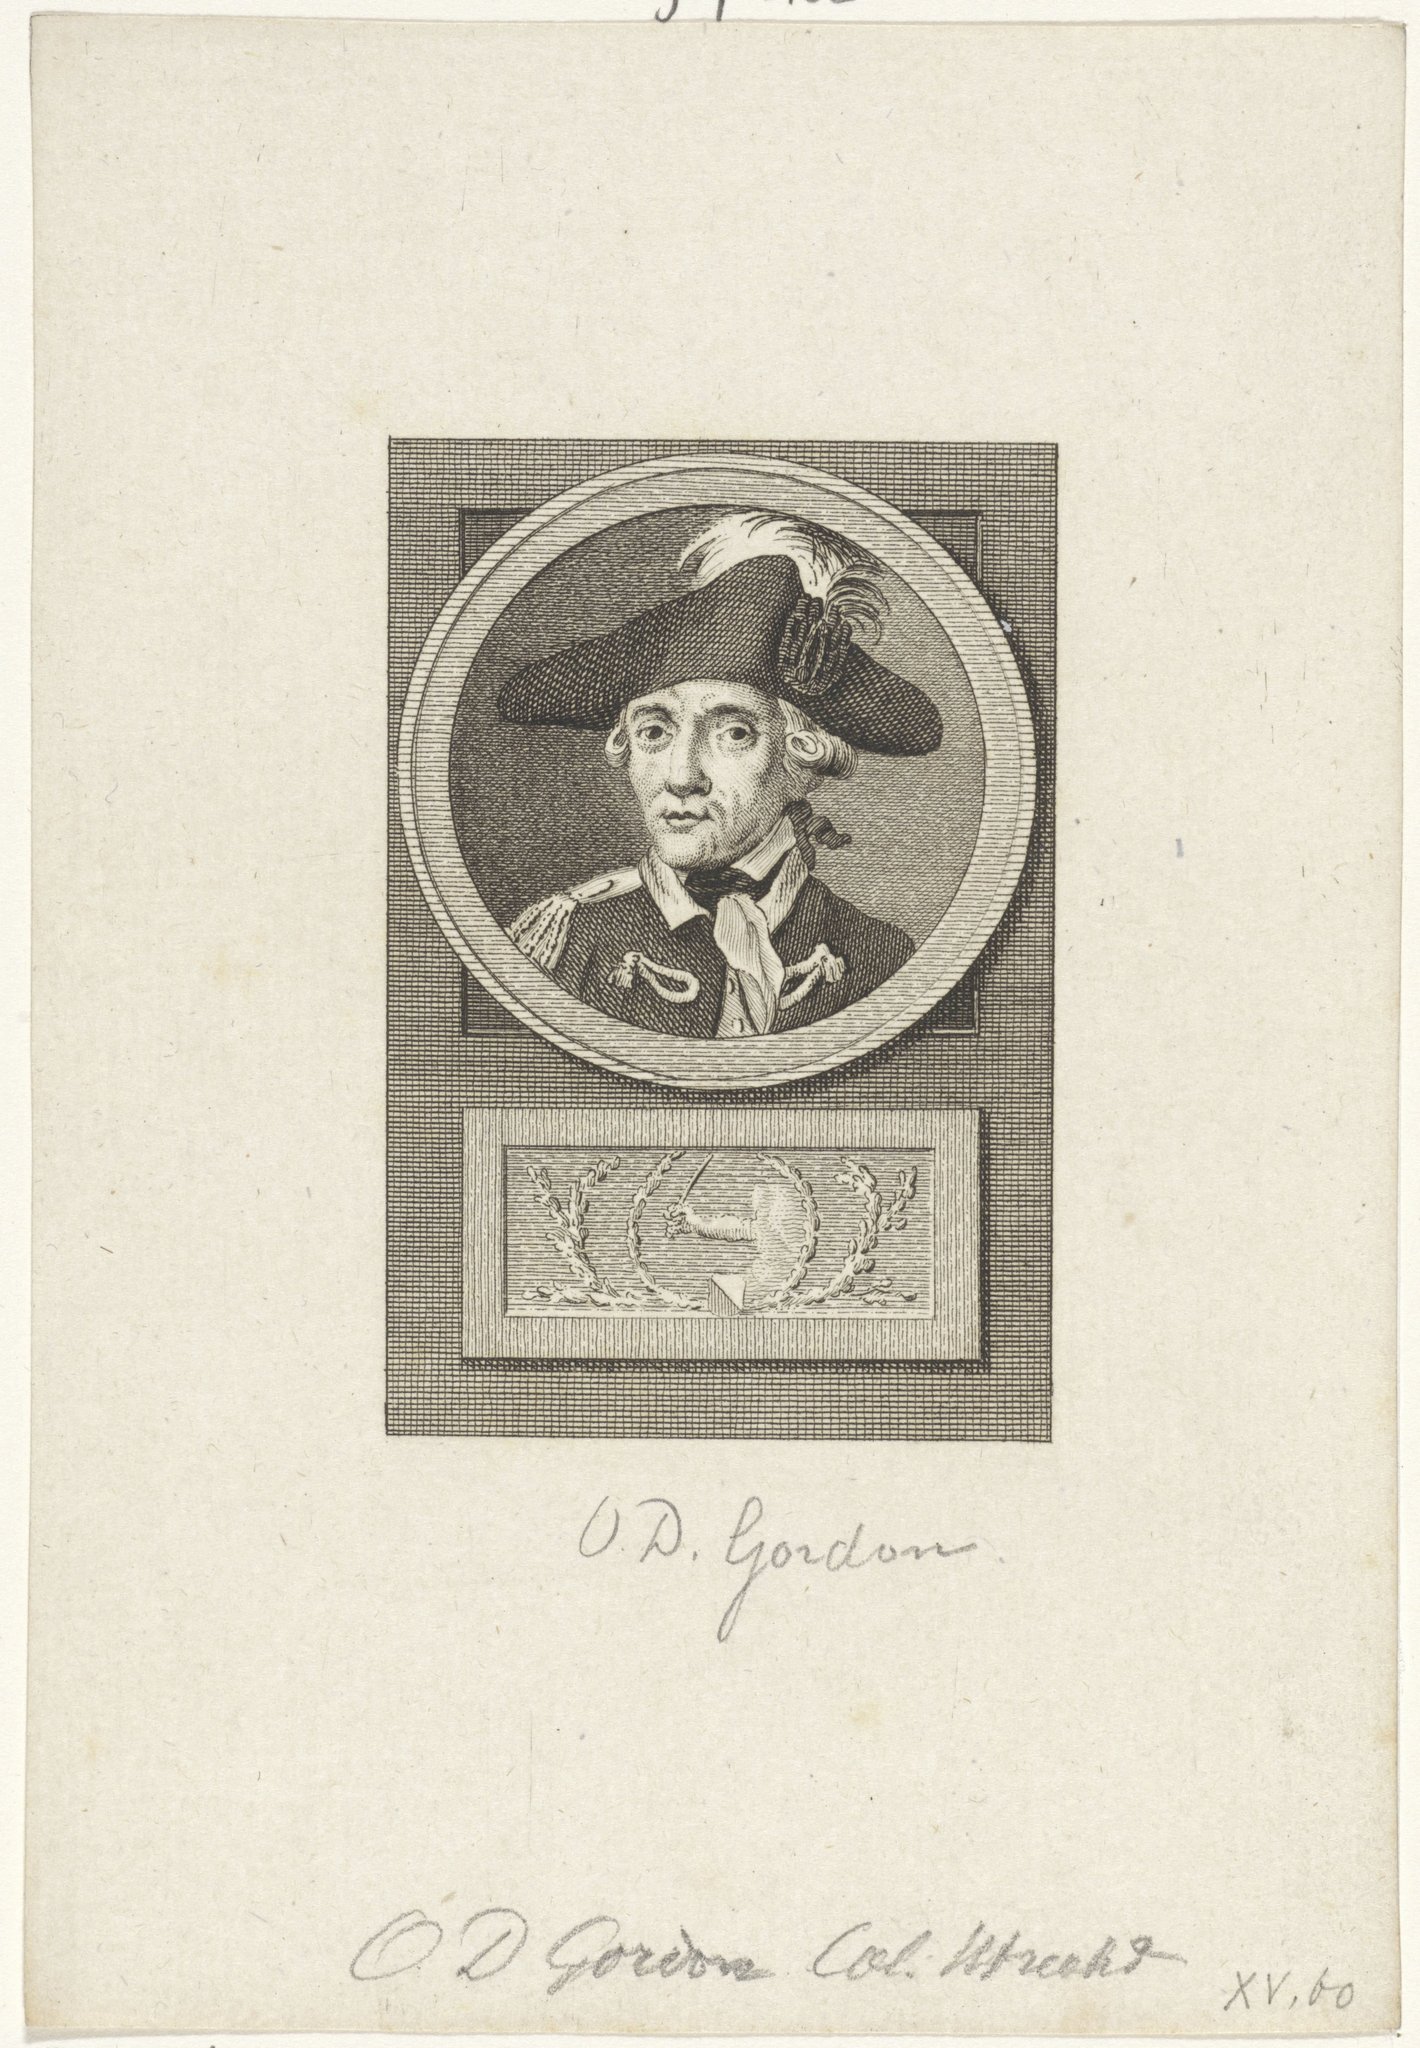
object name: print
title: Portret van Otto Derk Gordon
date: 1783-1795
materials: paper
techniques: engraving, etching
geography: amsterdam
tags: utrecht, otto derk gordon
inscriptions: collector's mark: Lugt 2228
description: Latere staat prent gebruikt in: Fokke, Jan. Geschiedenissen der Vereenigde Nederlanden voor de vaderlandsche jeugd Ie-XXVste deel. Amsterdam: Johannes Allart, 1783-1795. Deel XV.